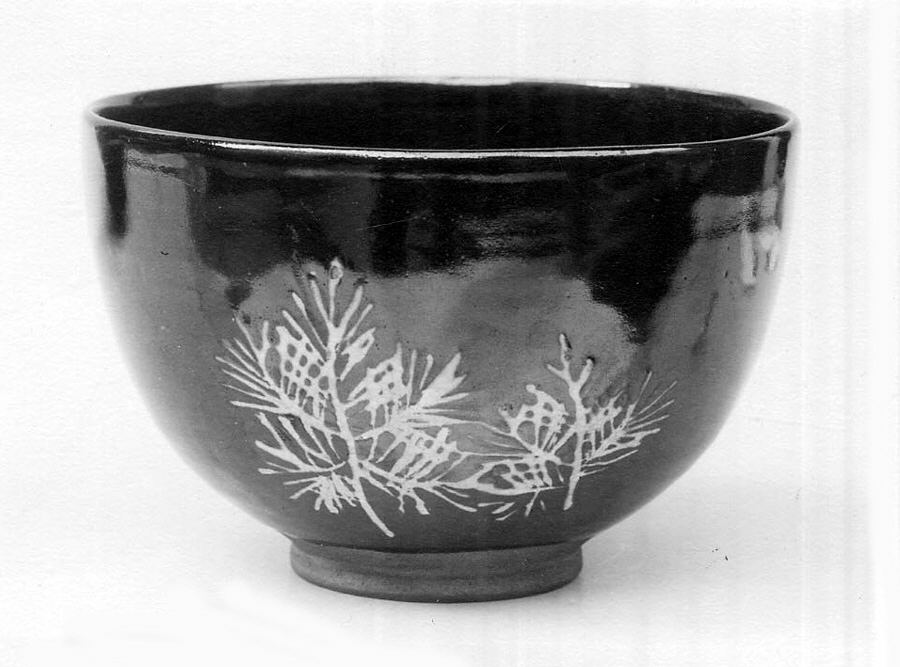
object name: teabowl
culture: japanese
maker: nin'ami dōhachi (takahashi dōhachi ii)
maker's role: artist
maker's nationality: japanese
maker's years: 1783-1855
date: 1850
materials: clay, glaze, wood